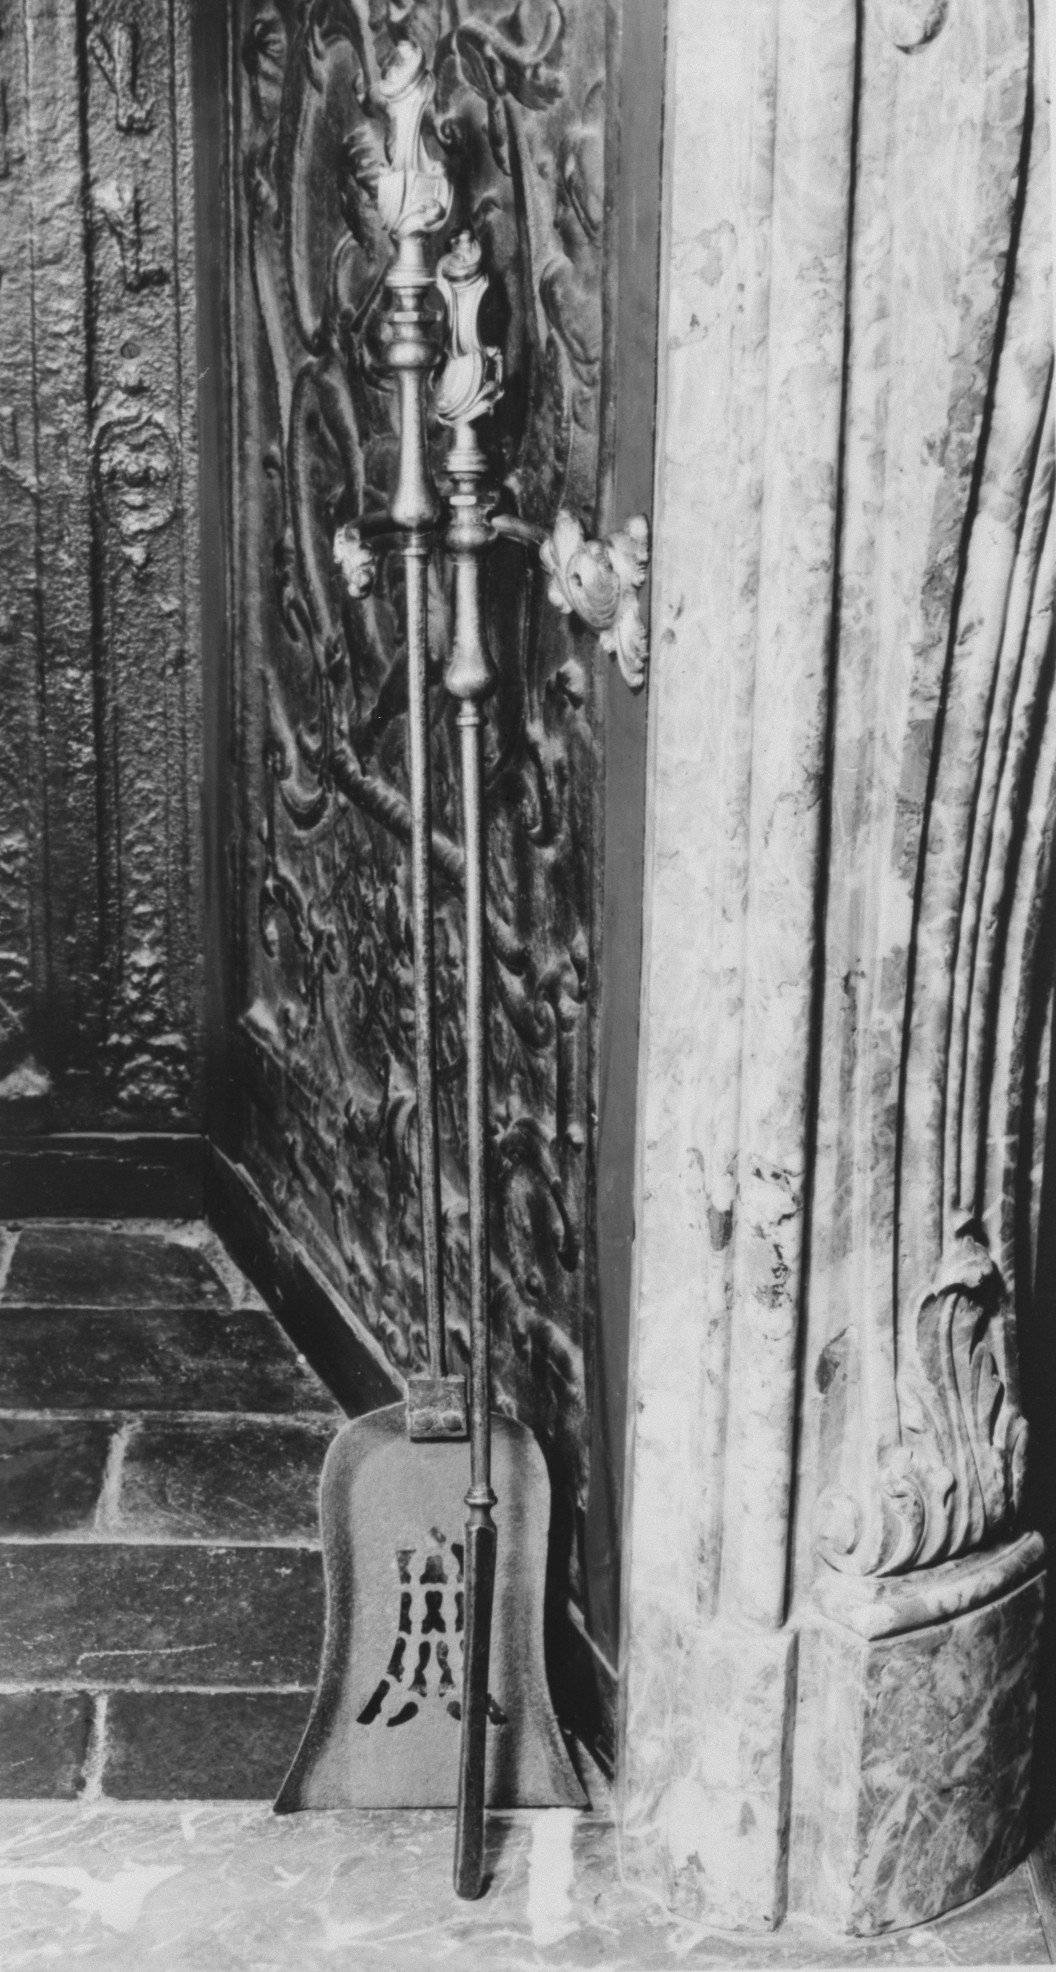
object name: poker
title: Poker (part of a set)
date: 1730-1760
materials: gilt bronze, steel